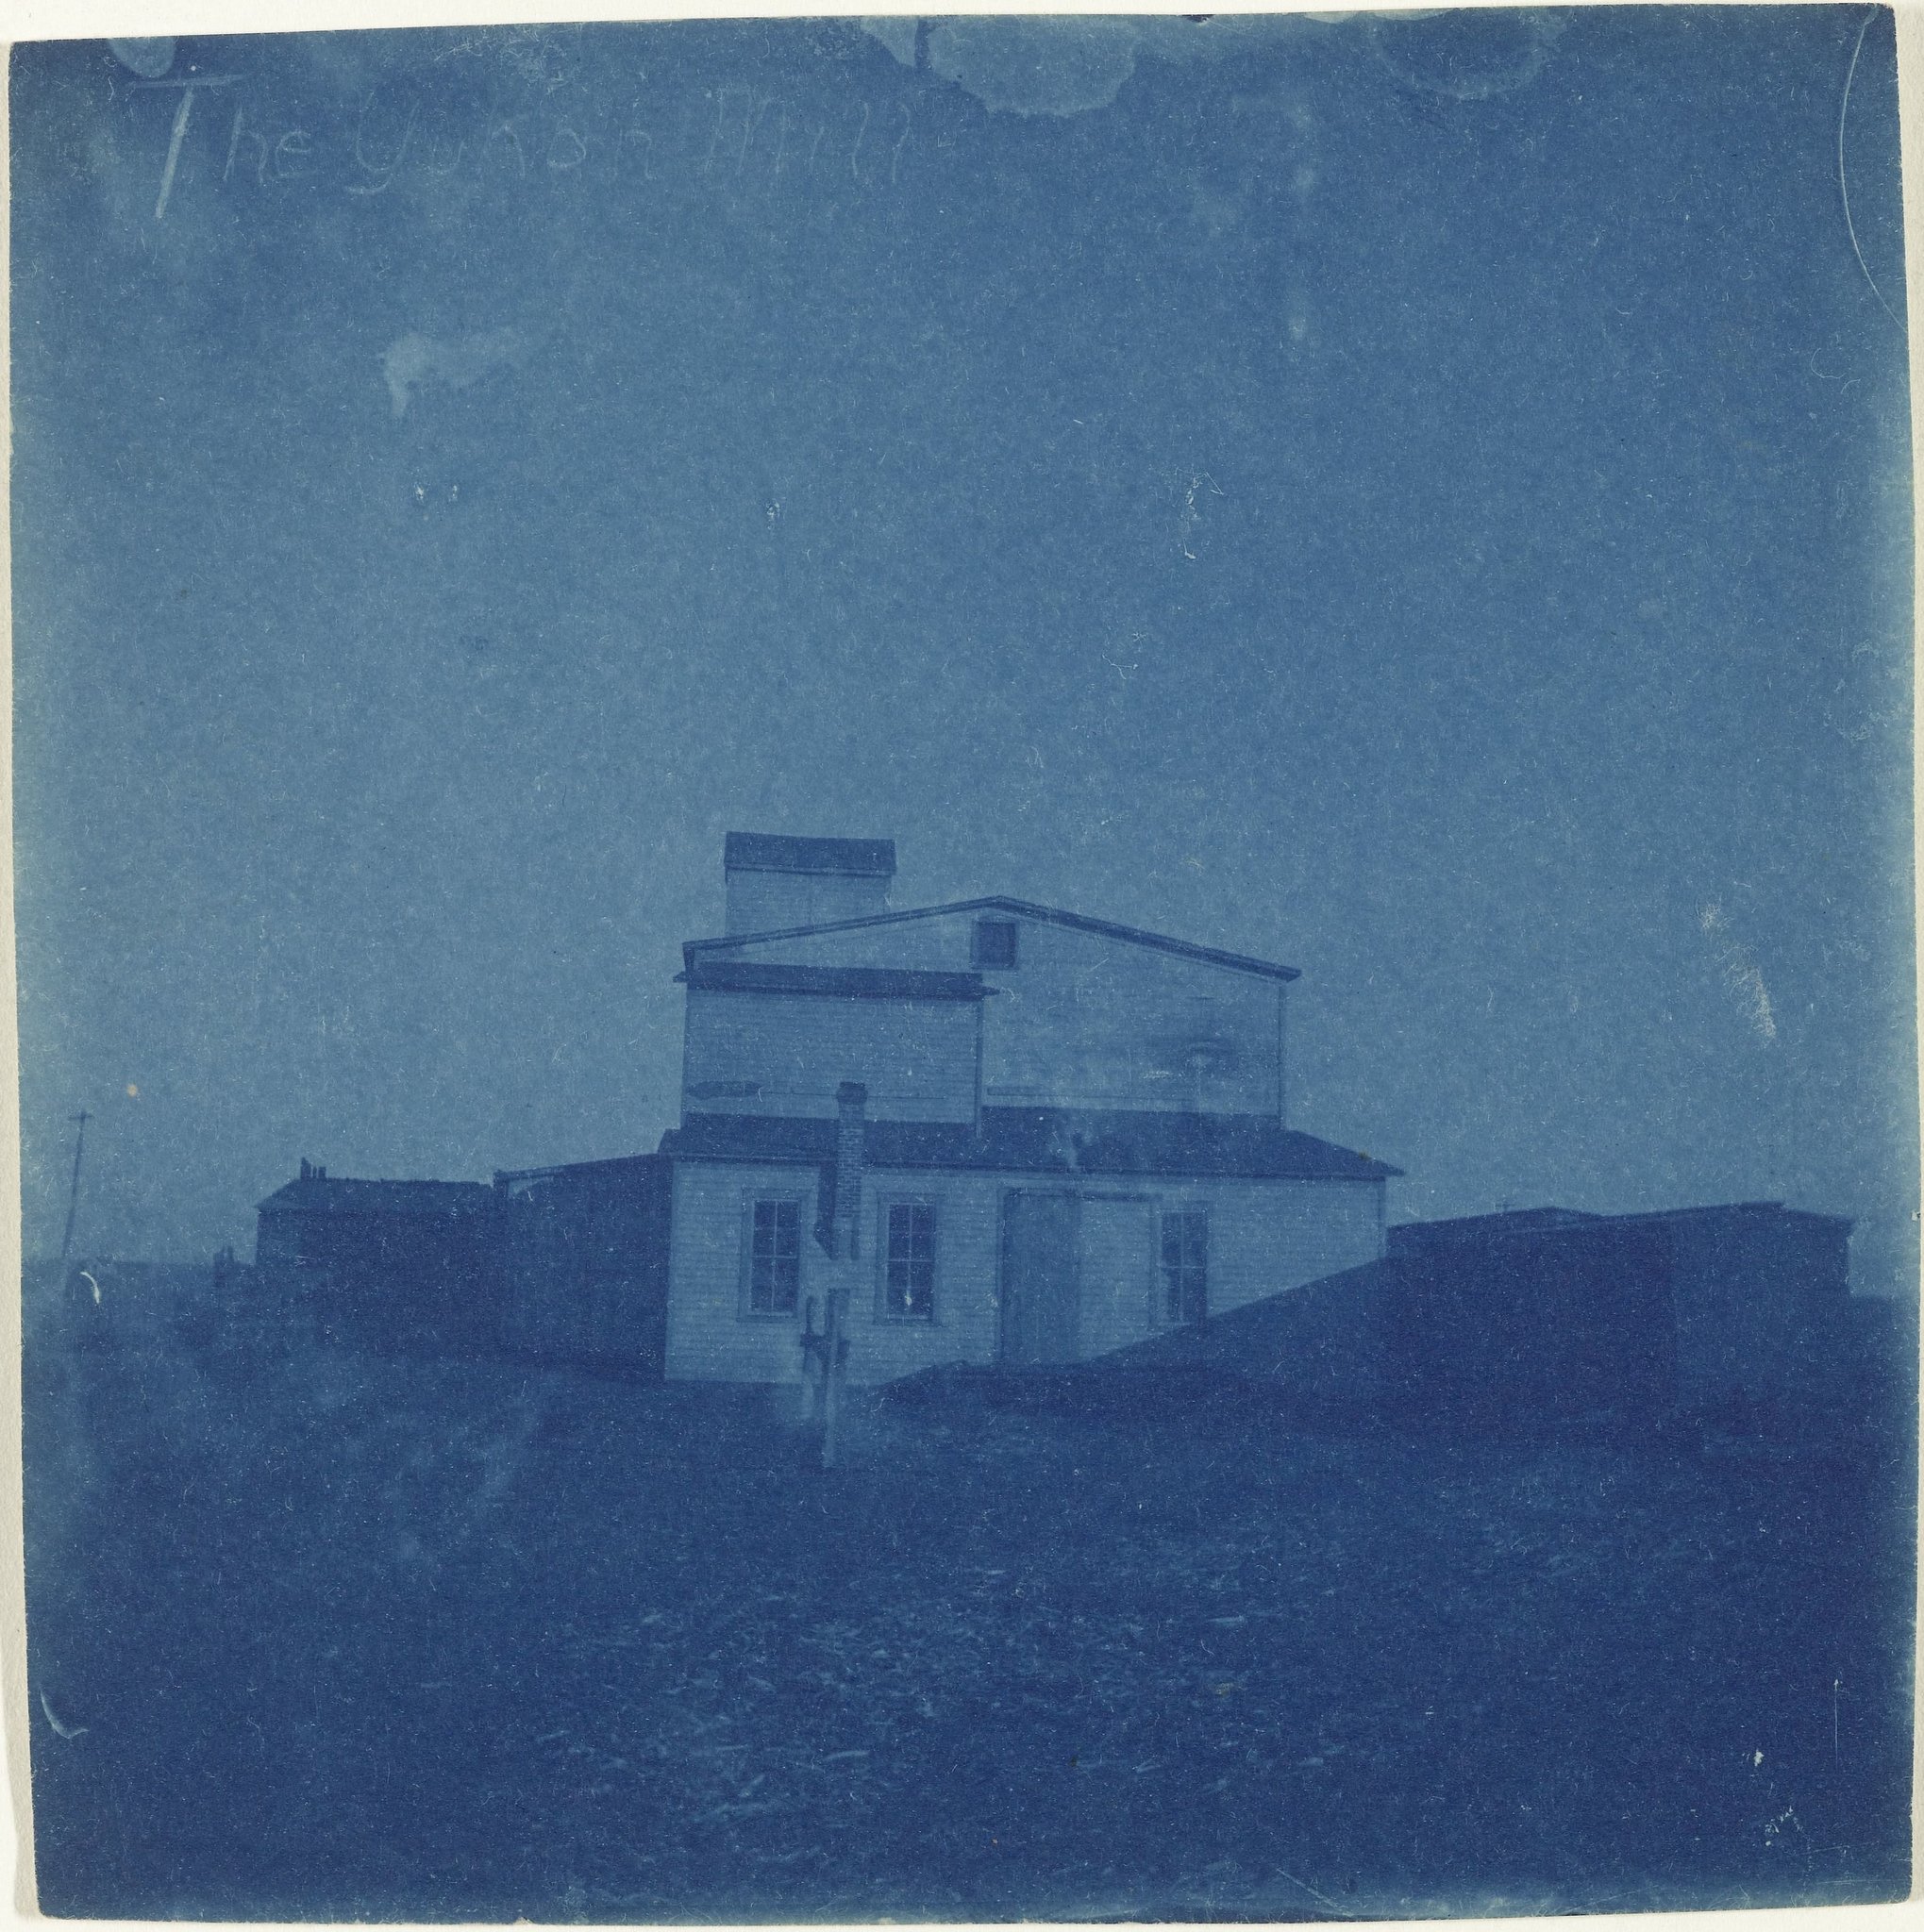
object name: photograph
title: Gebouw van de Yukon Mill and Grain Company, Yukon, Oklahoma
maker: Anonymous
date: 1900-1912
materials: paper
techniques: cyanotype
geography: yukon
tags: factory in landscape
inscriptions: annotation: ‘Yukon Mill’, date: ‘DEC 1900’